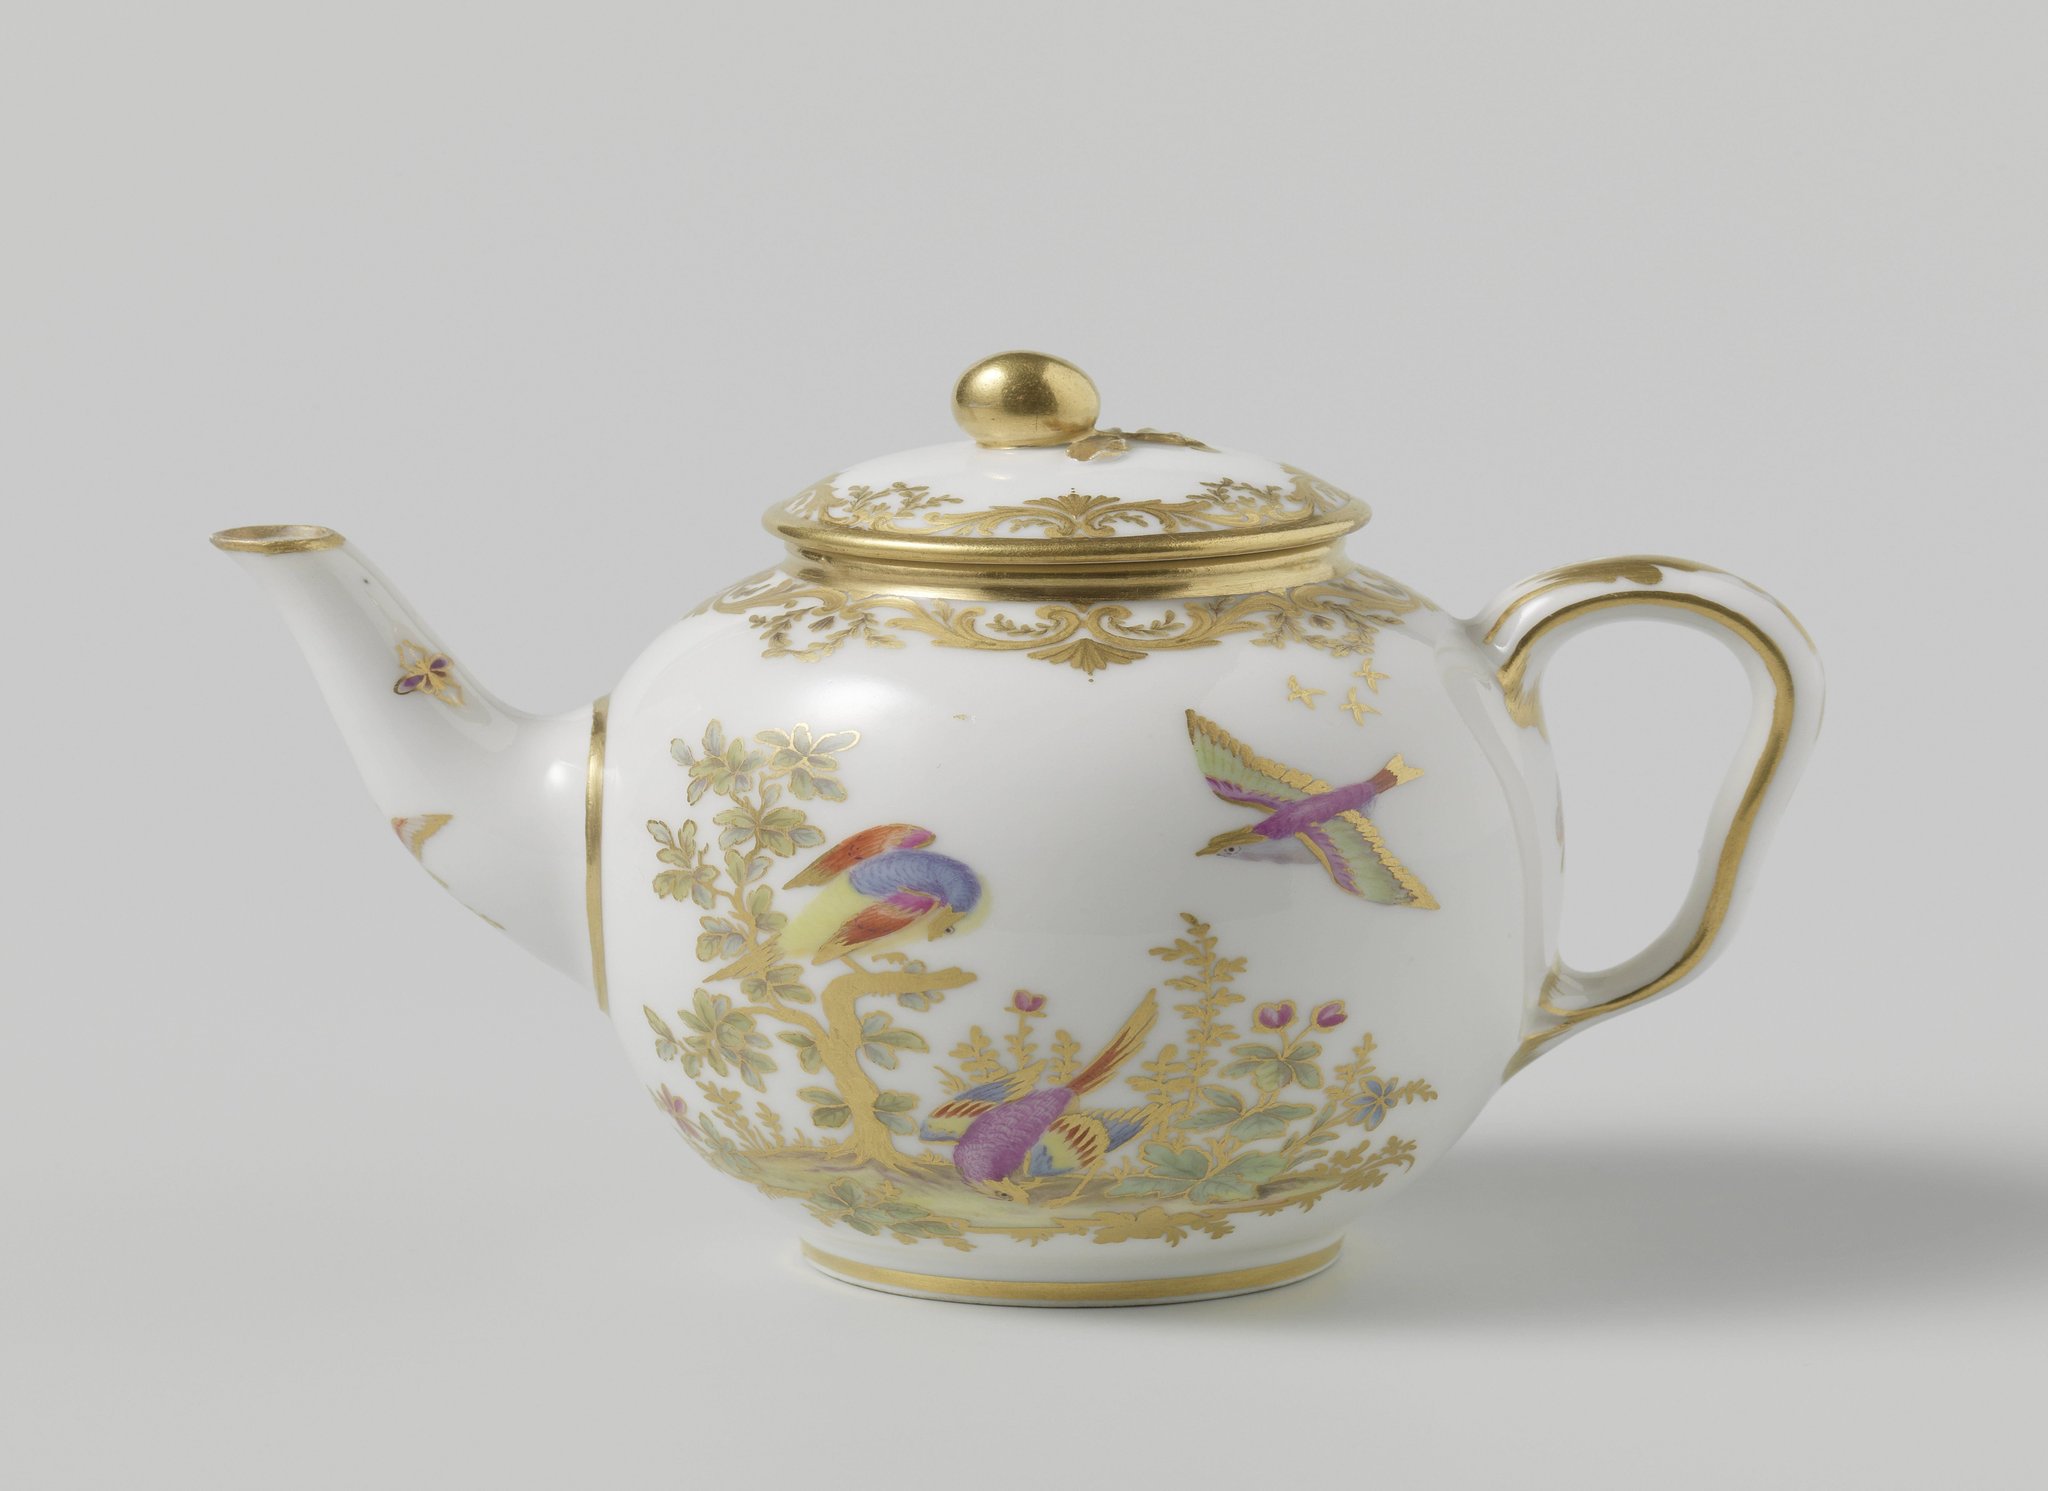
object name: teapot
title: Theepot, behorend bij een theeservies (déjeuner Bolvry)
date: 1779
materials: porcelain, silver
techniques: gilding, painted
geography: sèvres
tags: birds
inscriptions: painter's mark: ‘F.’, factory mark, mark: ‘Ma;’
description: Bolvormige theepot van veelkleurig beschilderd porselein, met een deksel, een tuit en een geknikt c-vormig oor. De vergulde knop van het deksel heeft de vorm van een vrucht aan een tak. Op de pot is een grond geschilderd waarop een boom en bloemen, met vogels in de boom, op de grond en in de lucht. De theepot is gemerkt.